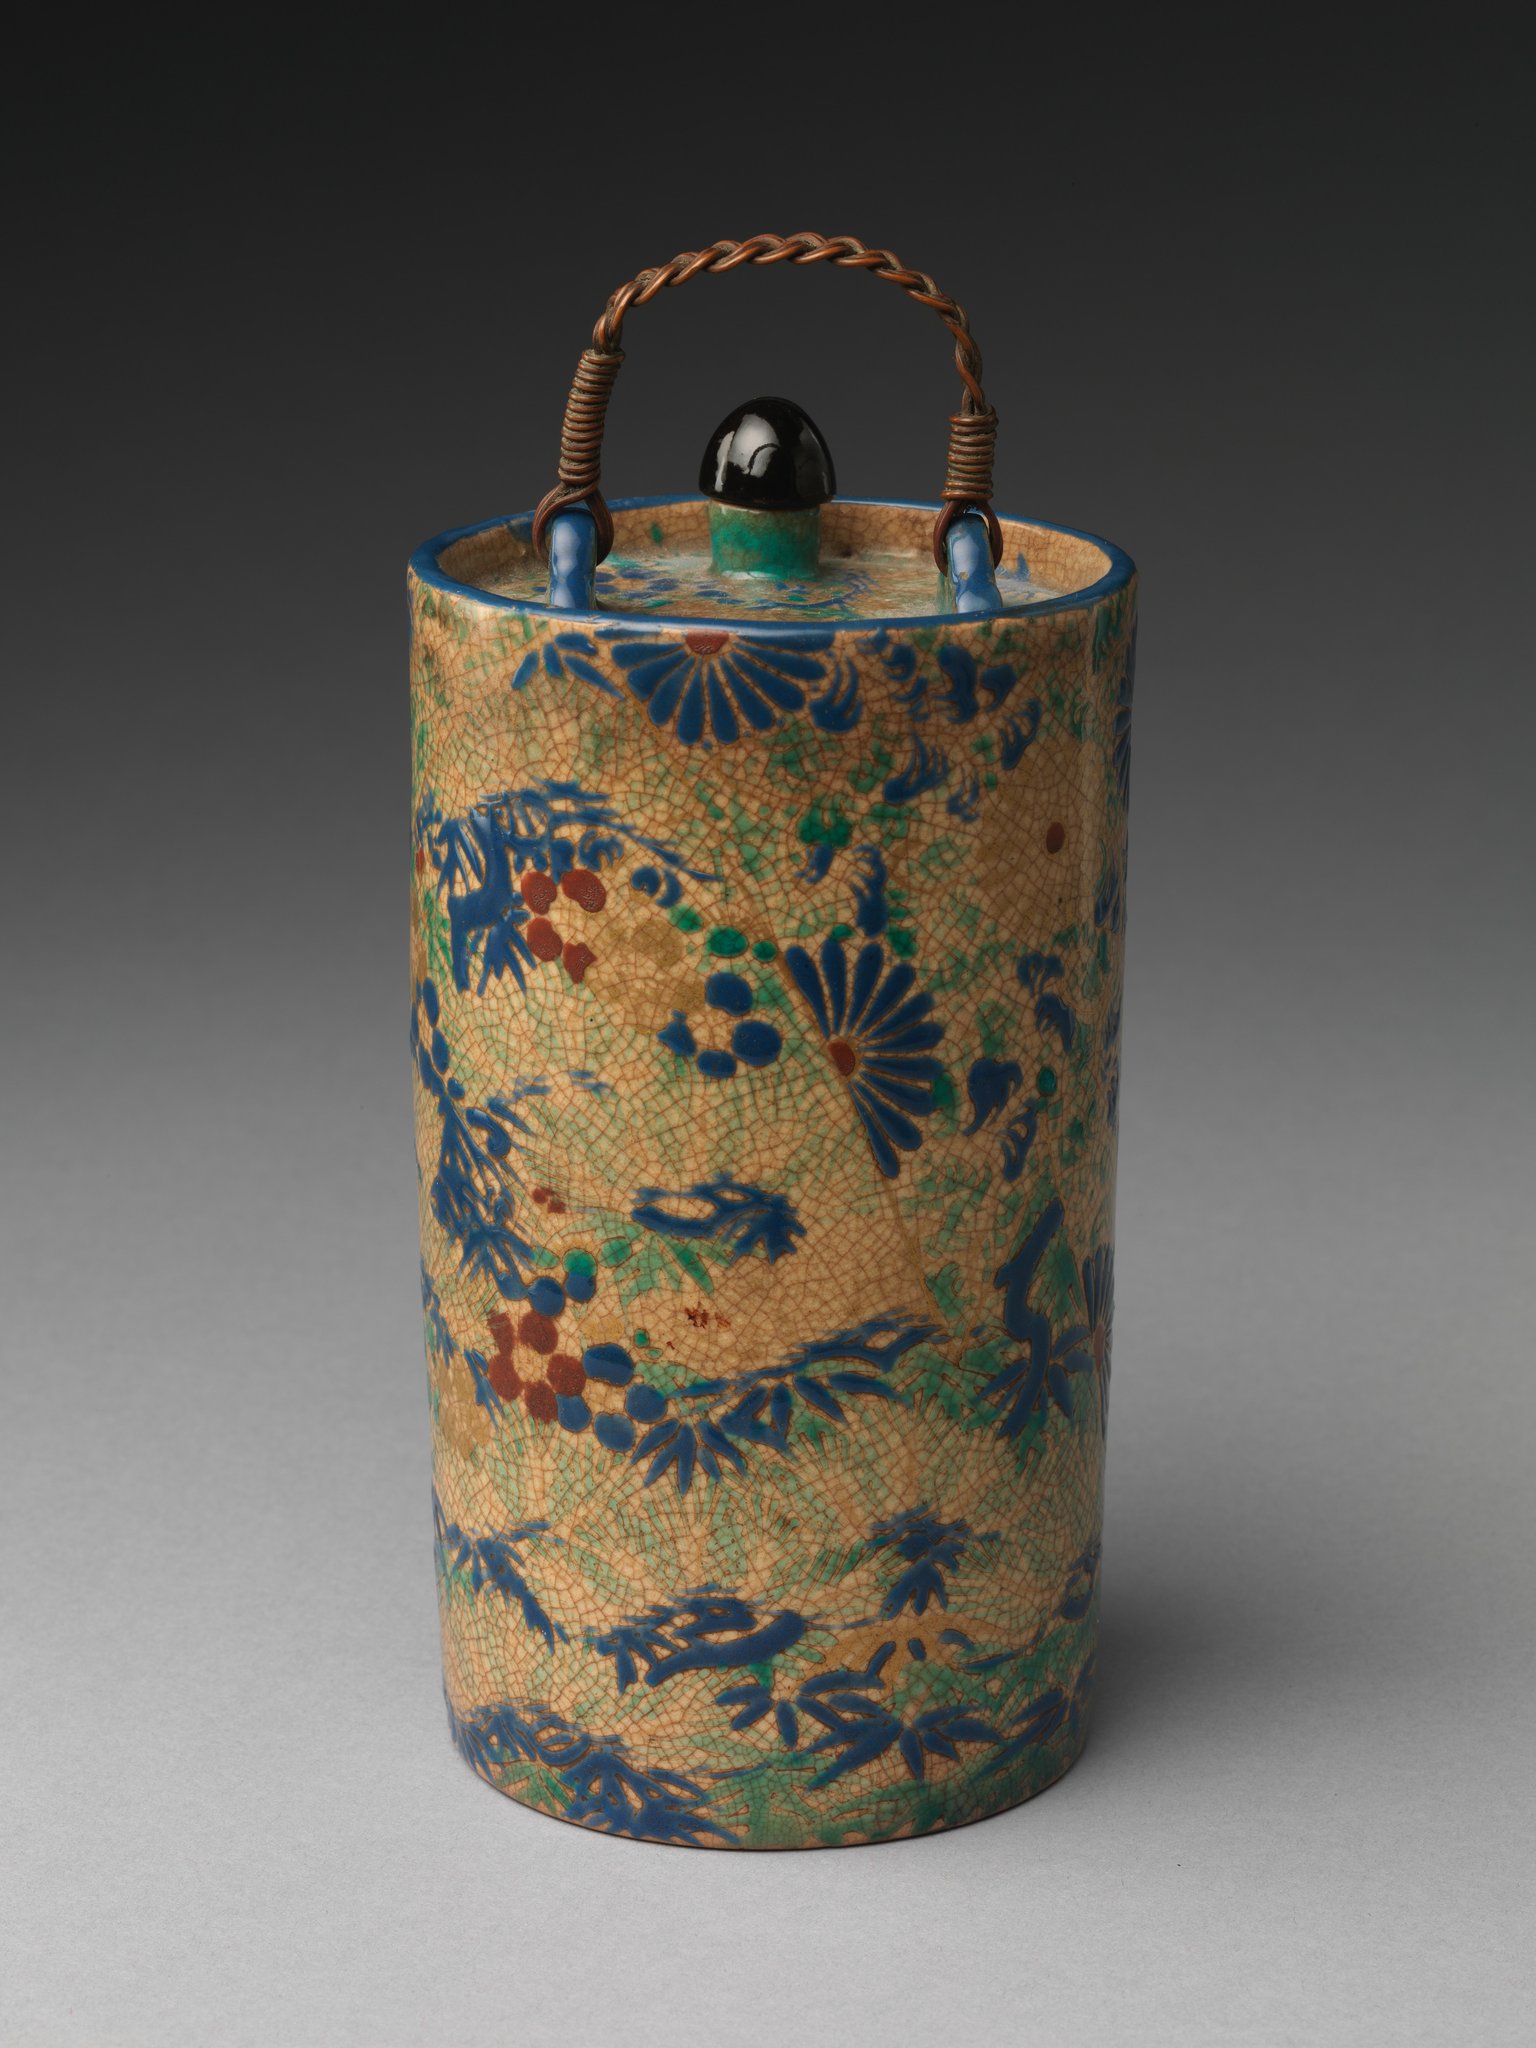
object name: wine ewer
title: Wine ewer with stopper (Tokkuri)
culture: japanese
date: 1667-1733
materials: enamel, stoneware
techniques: polychrome